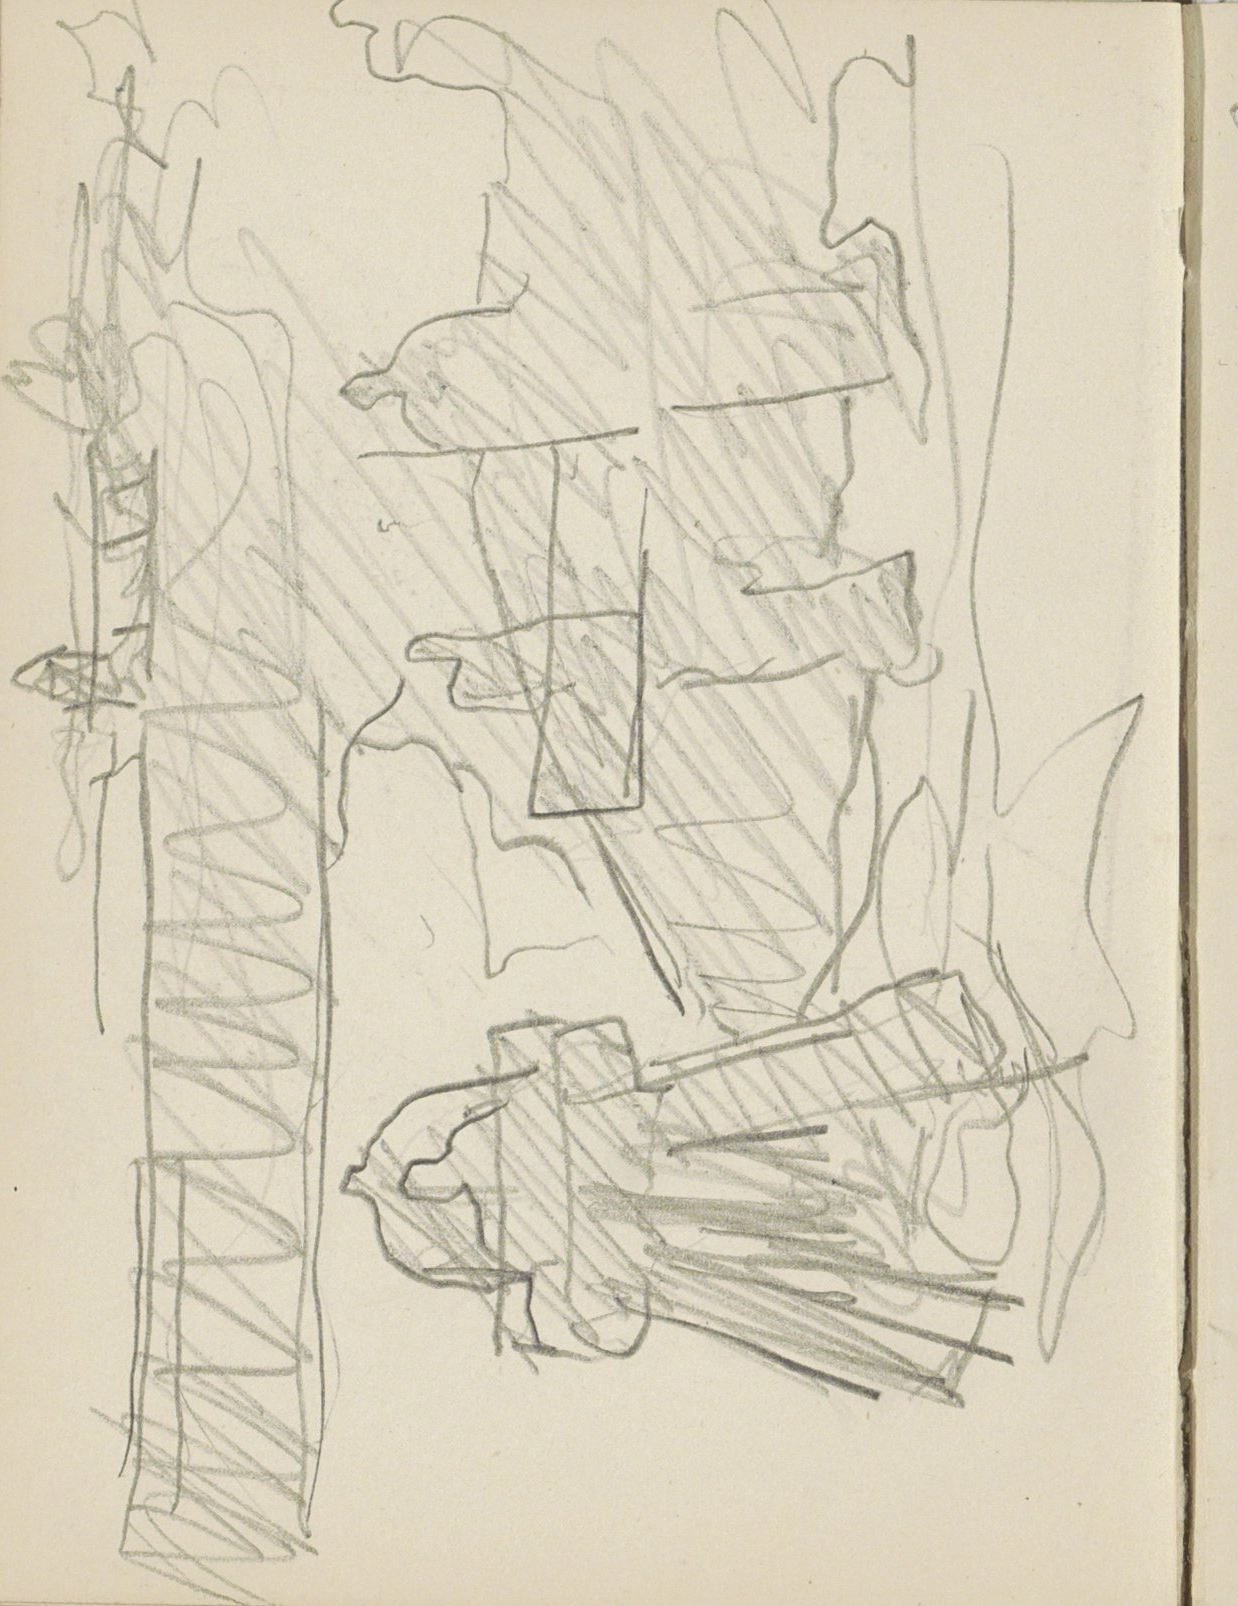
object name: sketchbook leaf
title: Architectuur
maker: reijer stolk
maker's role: draughtsman, print maker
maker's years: 1896-1945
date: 1906-1945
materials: paper, pencil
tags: architecture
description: Onder andere een toren. Blad 45 verso uit een schetsboek met 69 bladen.